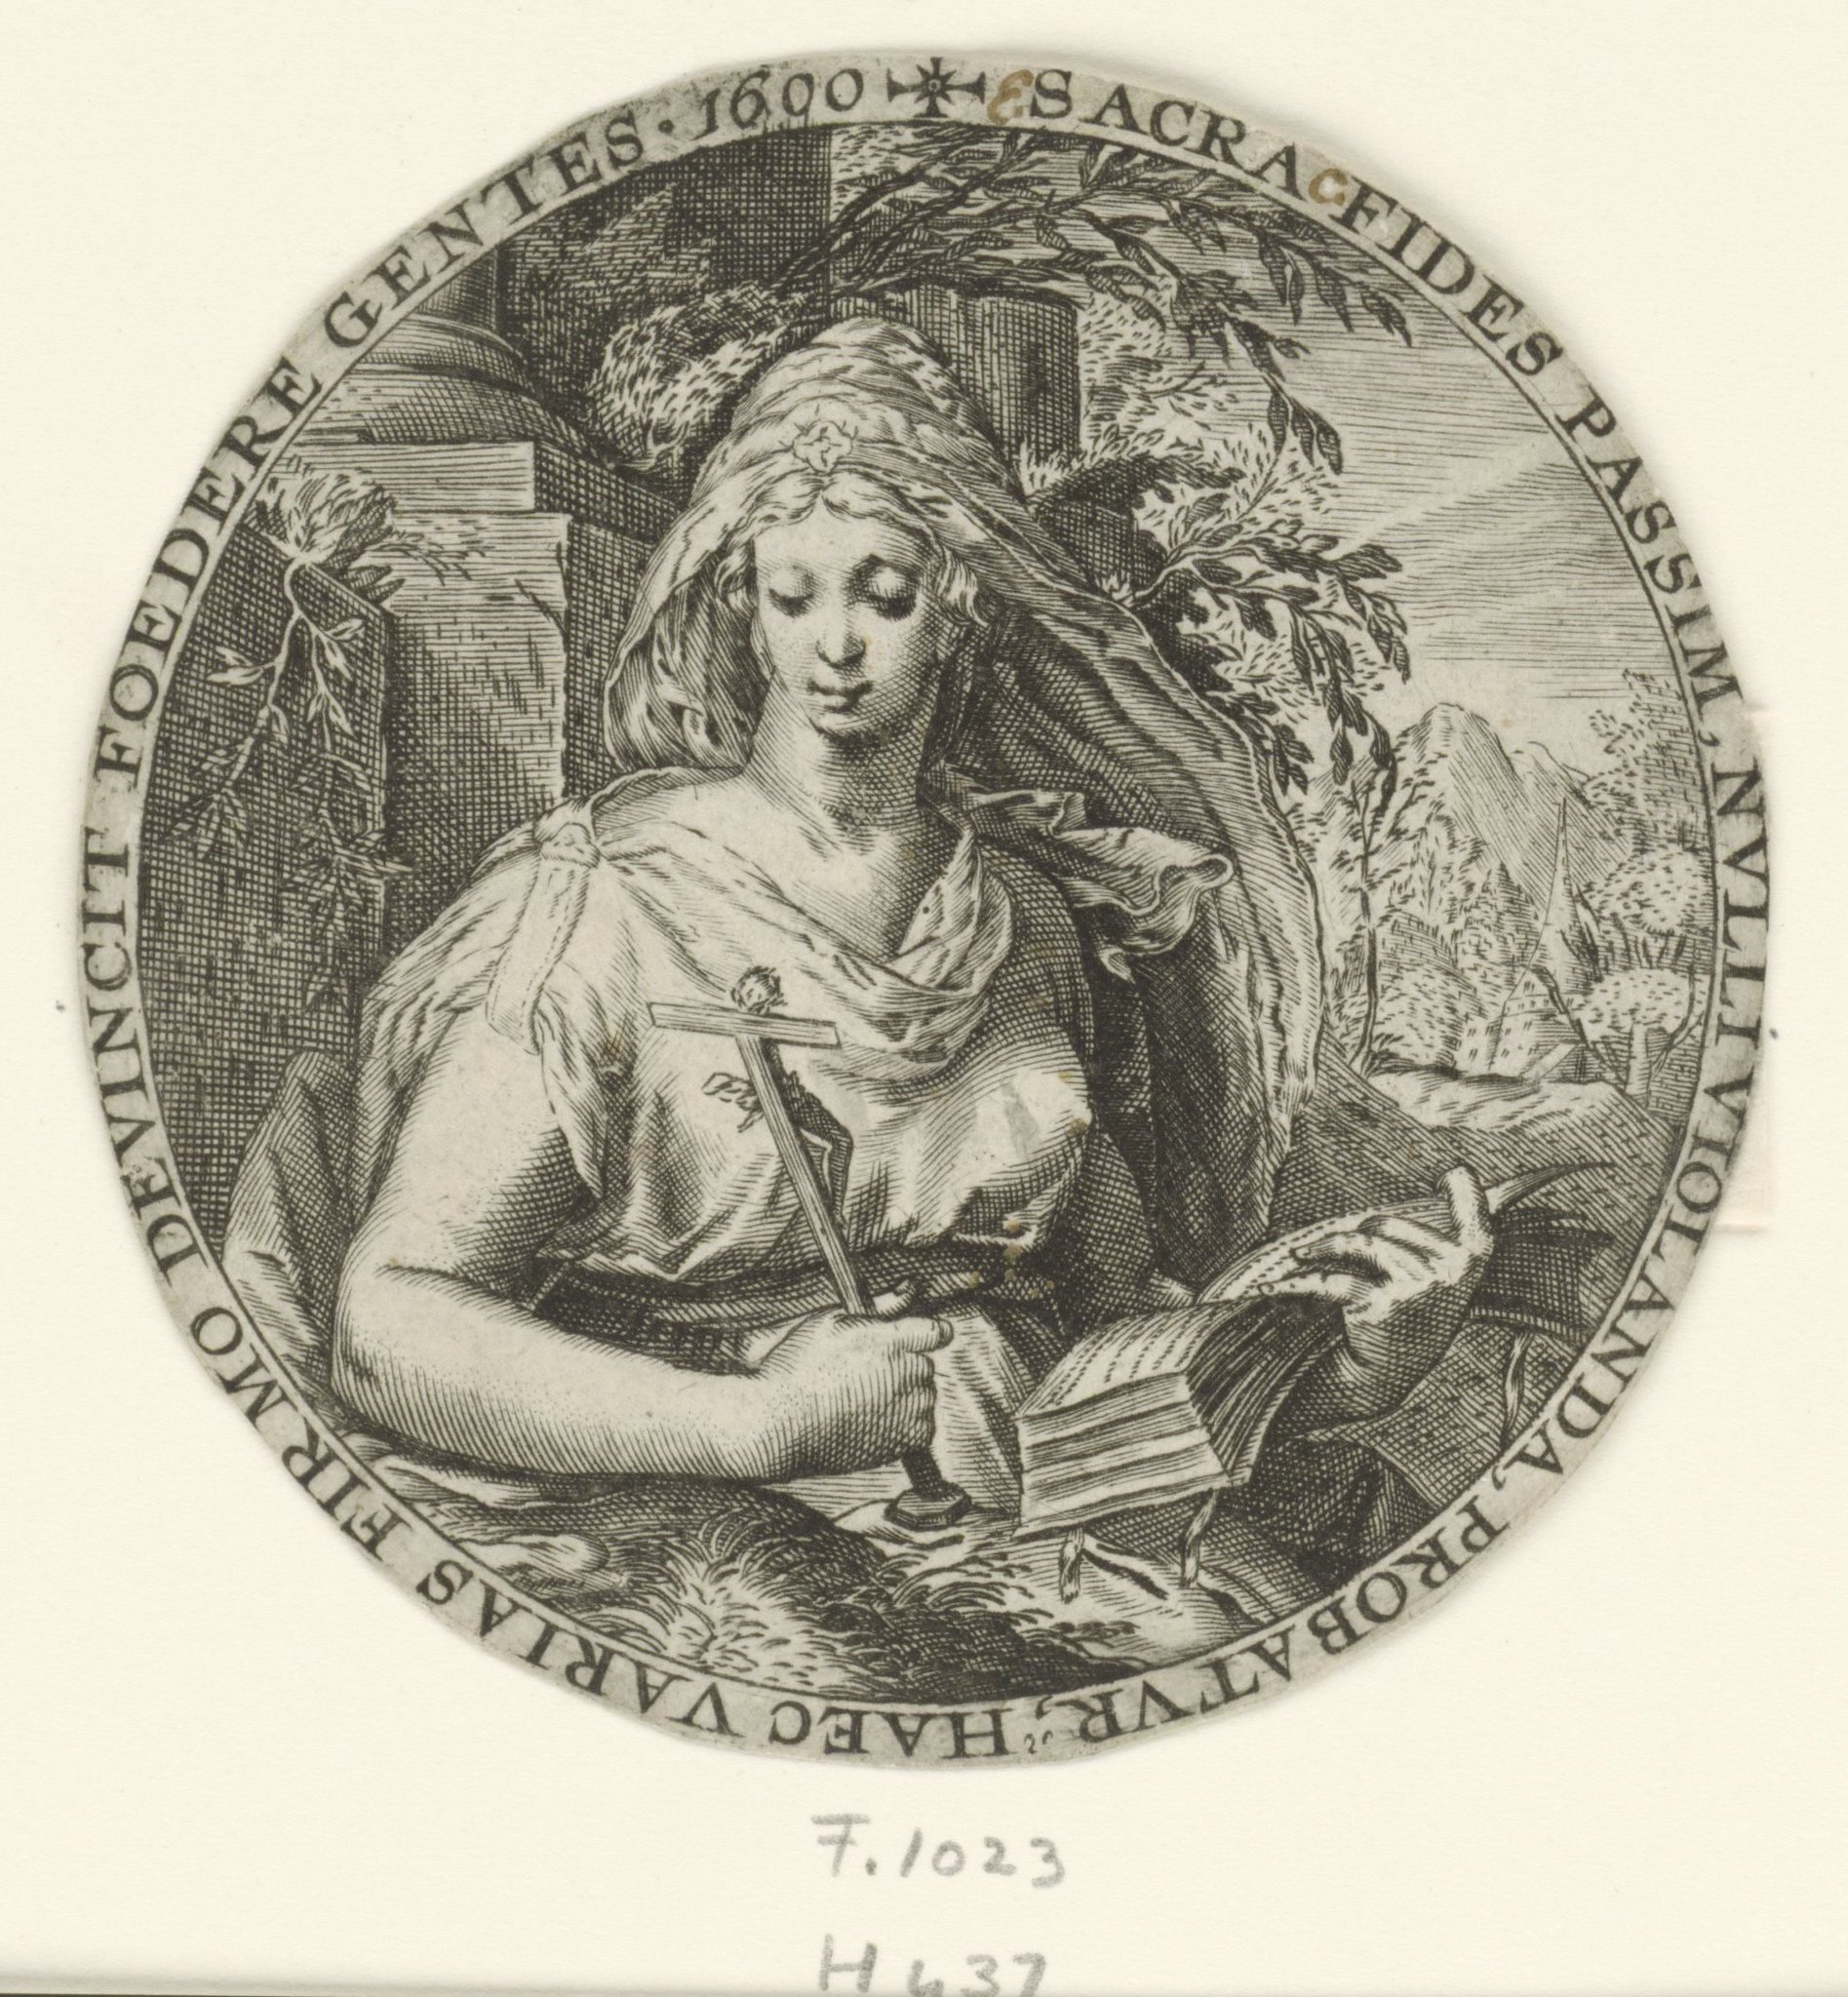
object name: print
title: Virtutu Theologicaru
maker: crispijn van de passe (i)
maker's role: draughtsman, print maker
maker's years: 1564-1637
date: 1600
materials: paper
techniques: engraving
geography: cologne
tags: faith, 'fides'; 'fede', 'fede catholica', 'fede christiana', 'fede christiana catholica' (ripa) ~ one of the three theological virtues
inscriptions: date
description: De vrouwelijke personificatie van Geloof (Fides), een van de drie theologische deugden, met een crucifix en een opengeslagen boek in haar handen. Prent uit een serie met theologische deugden.